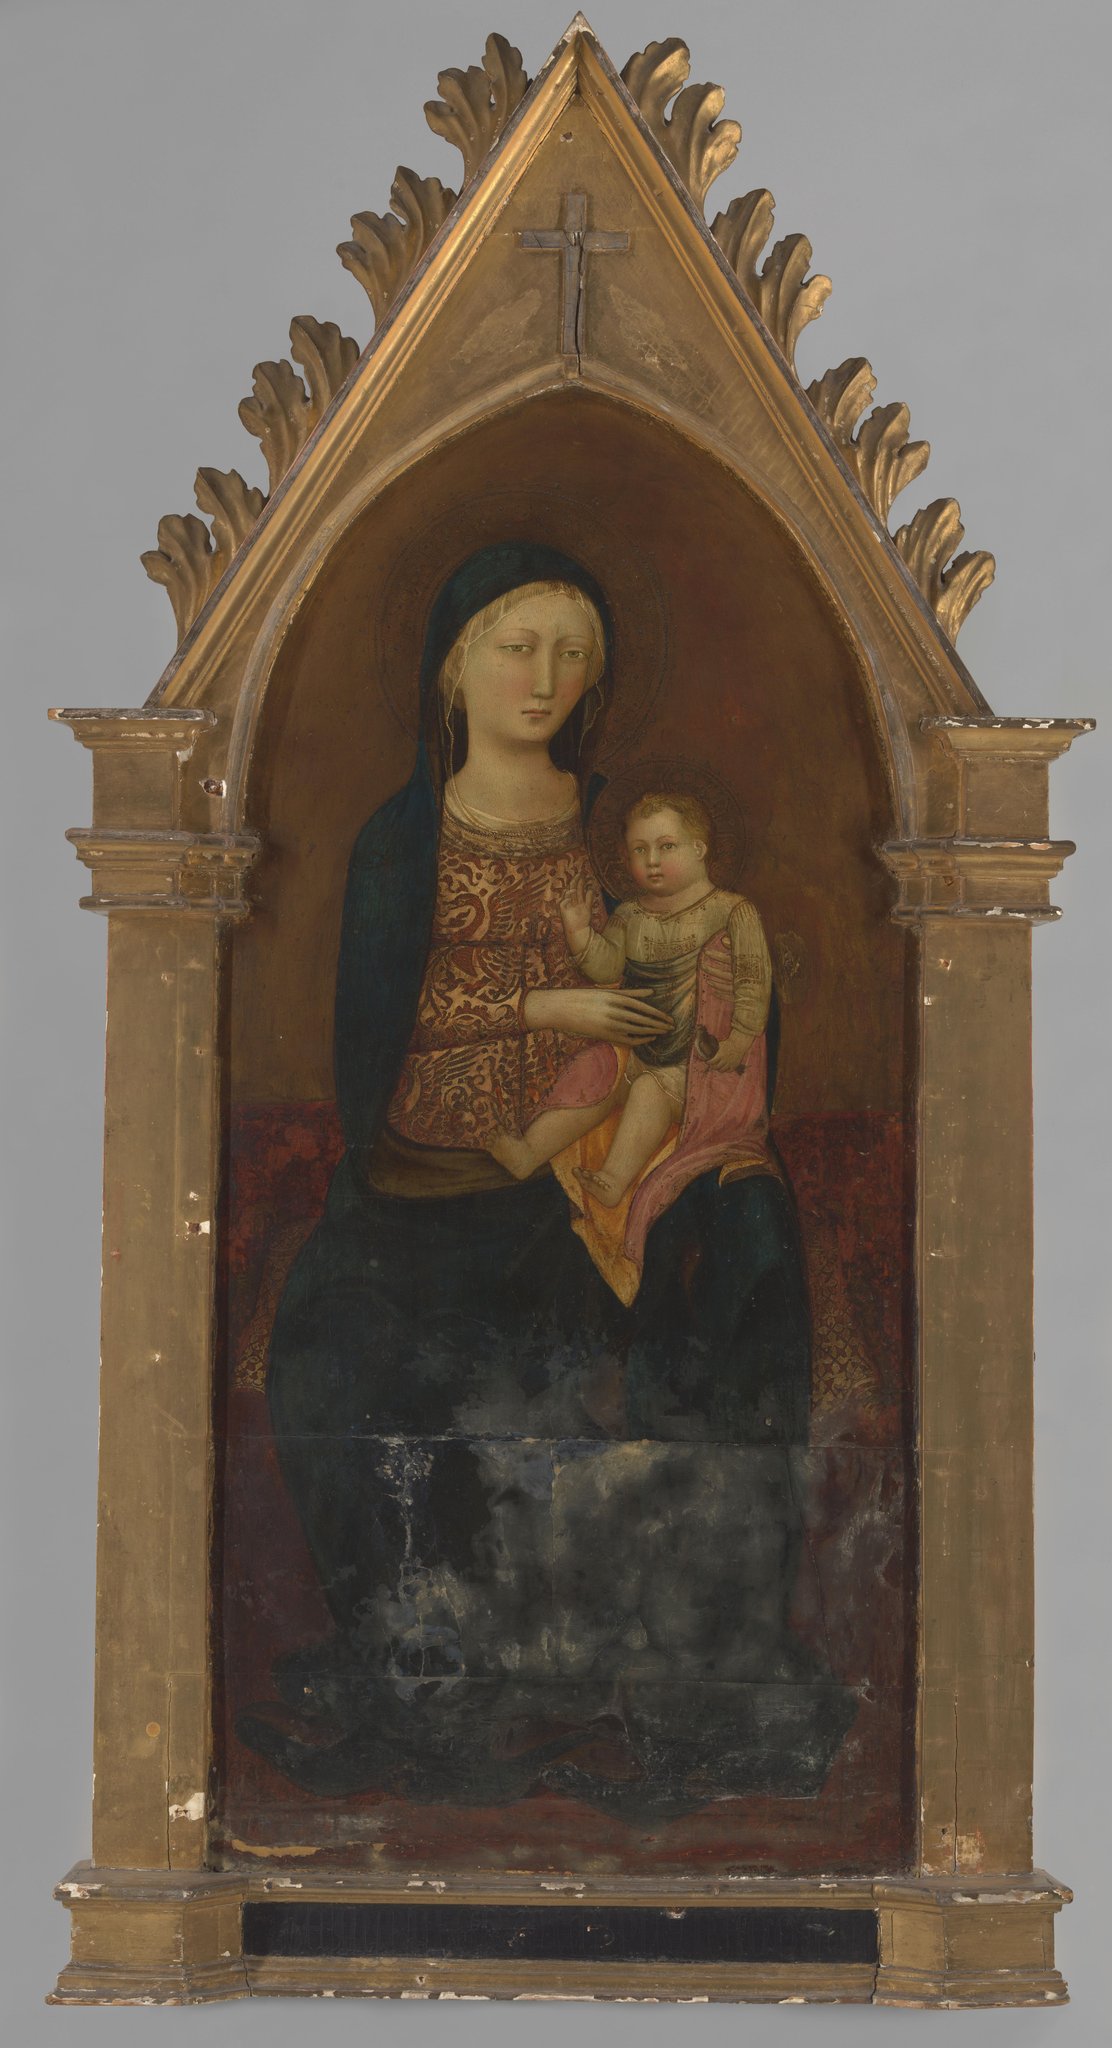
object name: painting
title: Virgin and Child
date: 1400-1425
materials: panel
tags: madonna: mary sitting or enthroned, the christ-child in her lap (or in front of her bosom) (mary sometimes represented half-length)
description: Maria zittend op een bank met het Christuskind op schoot. Met geïntegreerde lijst.